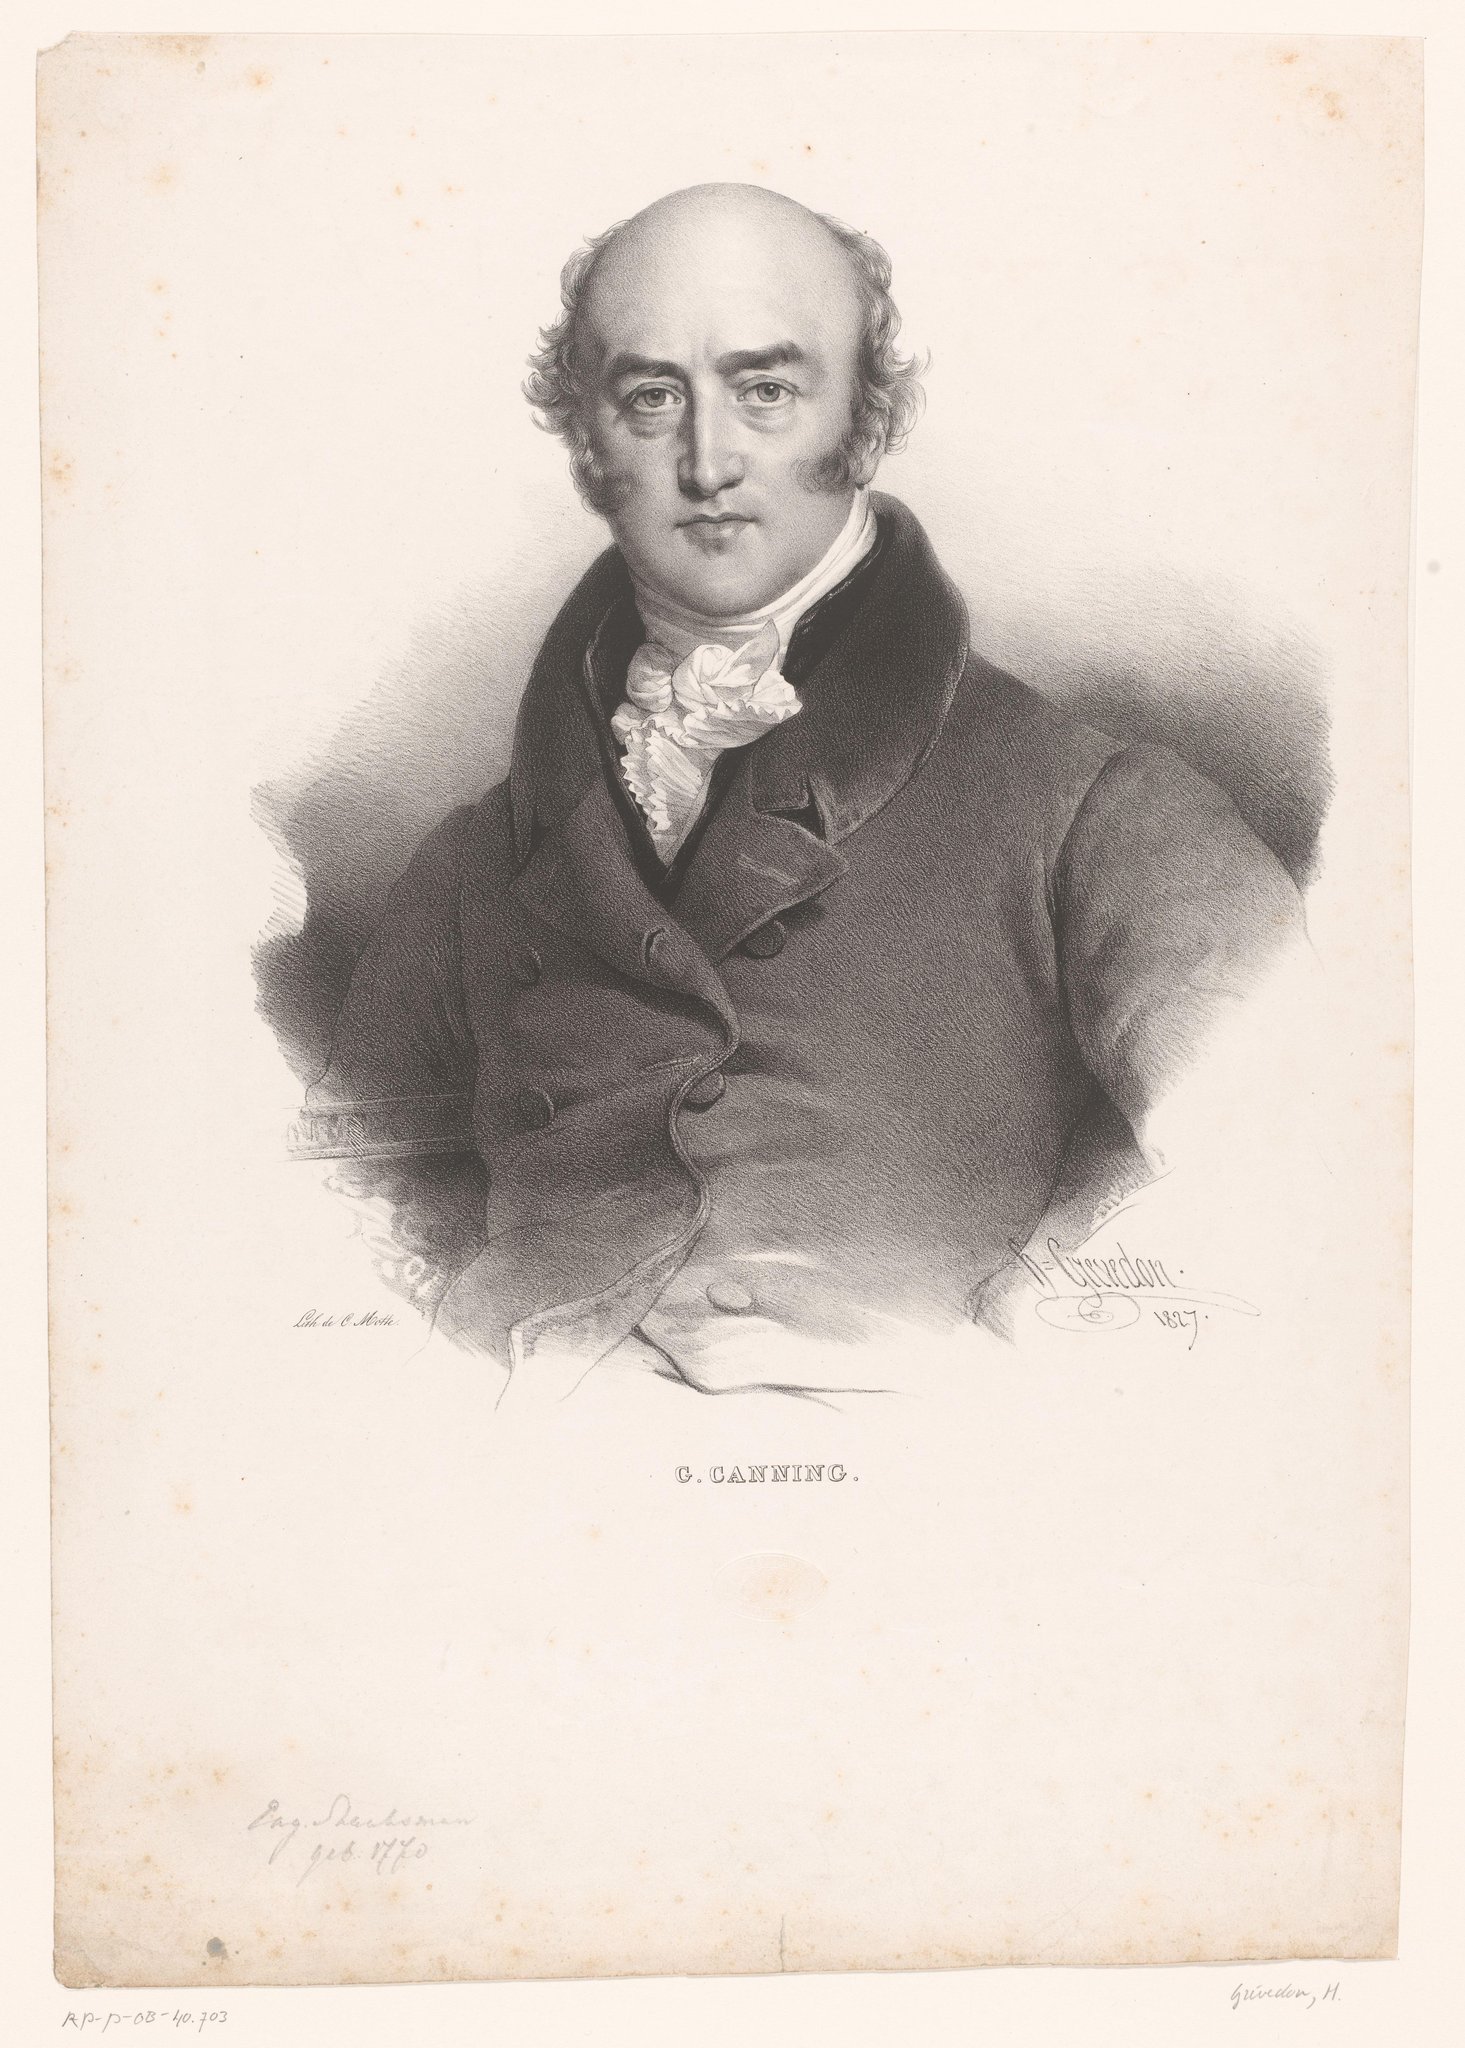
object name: print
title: Portret van George Canning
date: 1827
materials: paper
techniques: lithograph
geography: paris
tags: london, historical persons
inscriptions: check stamp: Lugt 3996